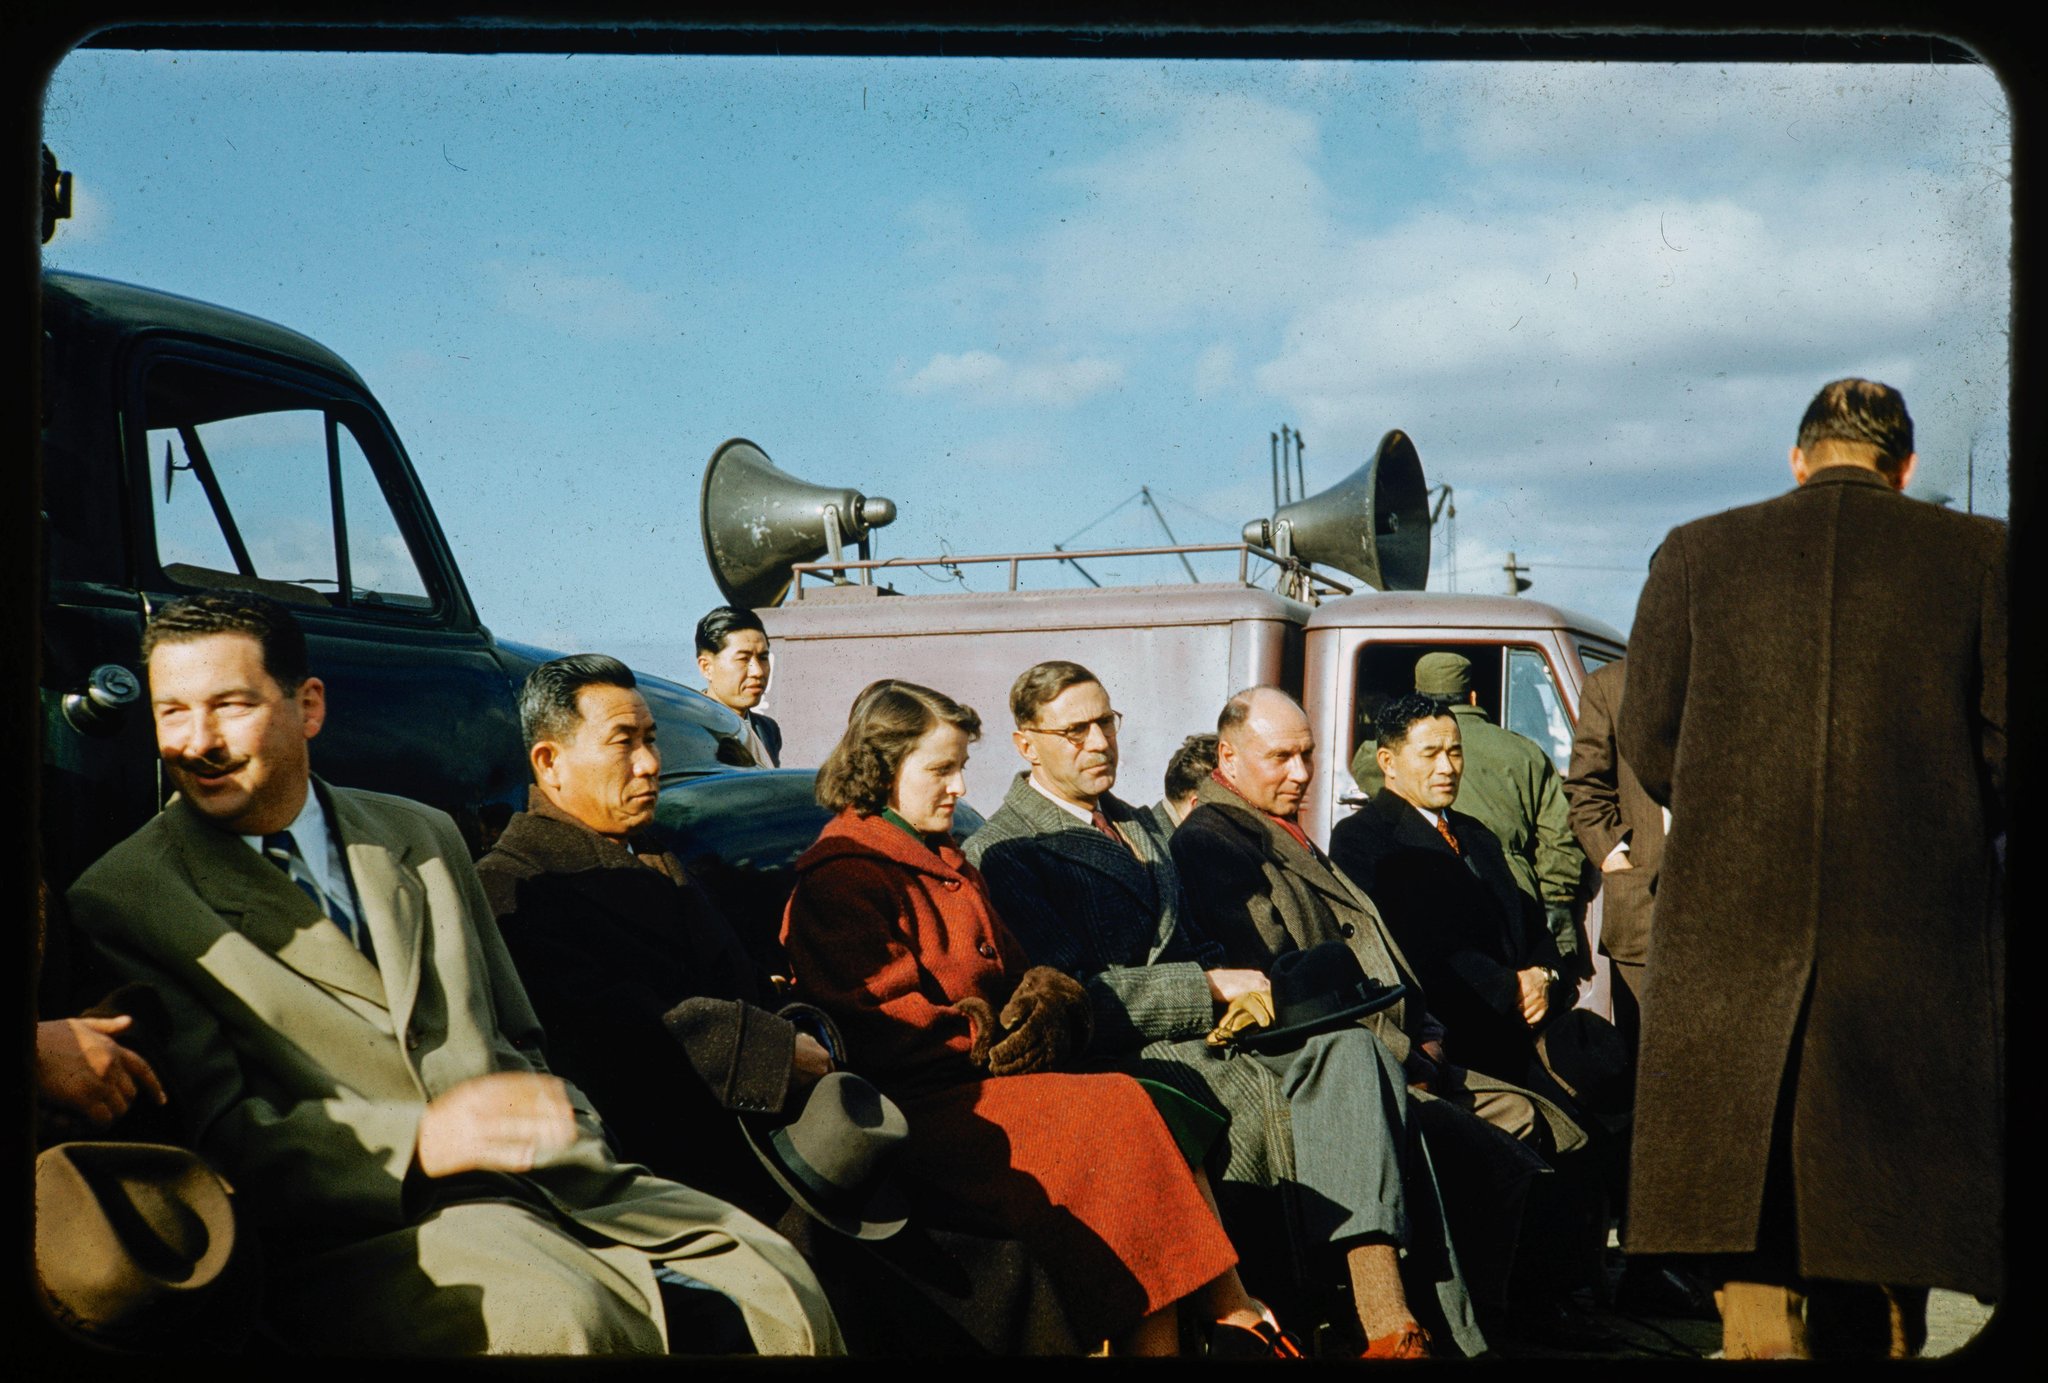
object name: color slide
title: Oorlog in Korea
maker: david ketel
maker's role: diplomaat, sinoloog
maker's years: 1913-2008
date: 1953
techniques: slide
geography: korea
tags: united nations, david ketel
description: Aankomst groep Europeanen waaronder David Ketel, met bril.